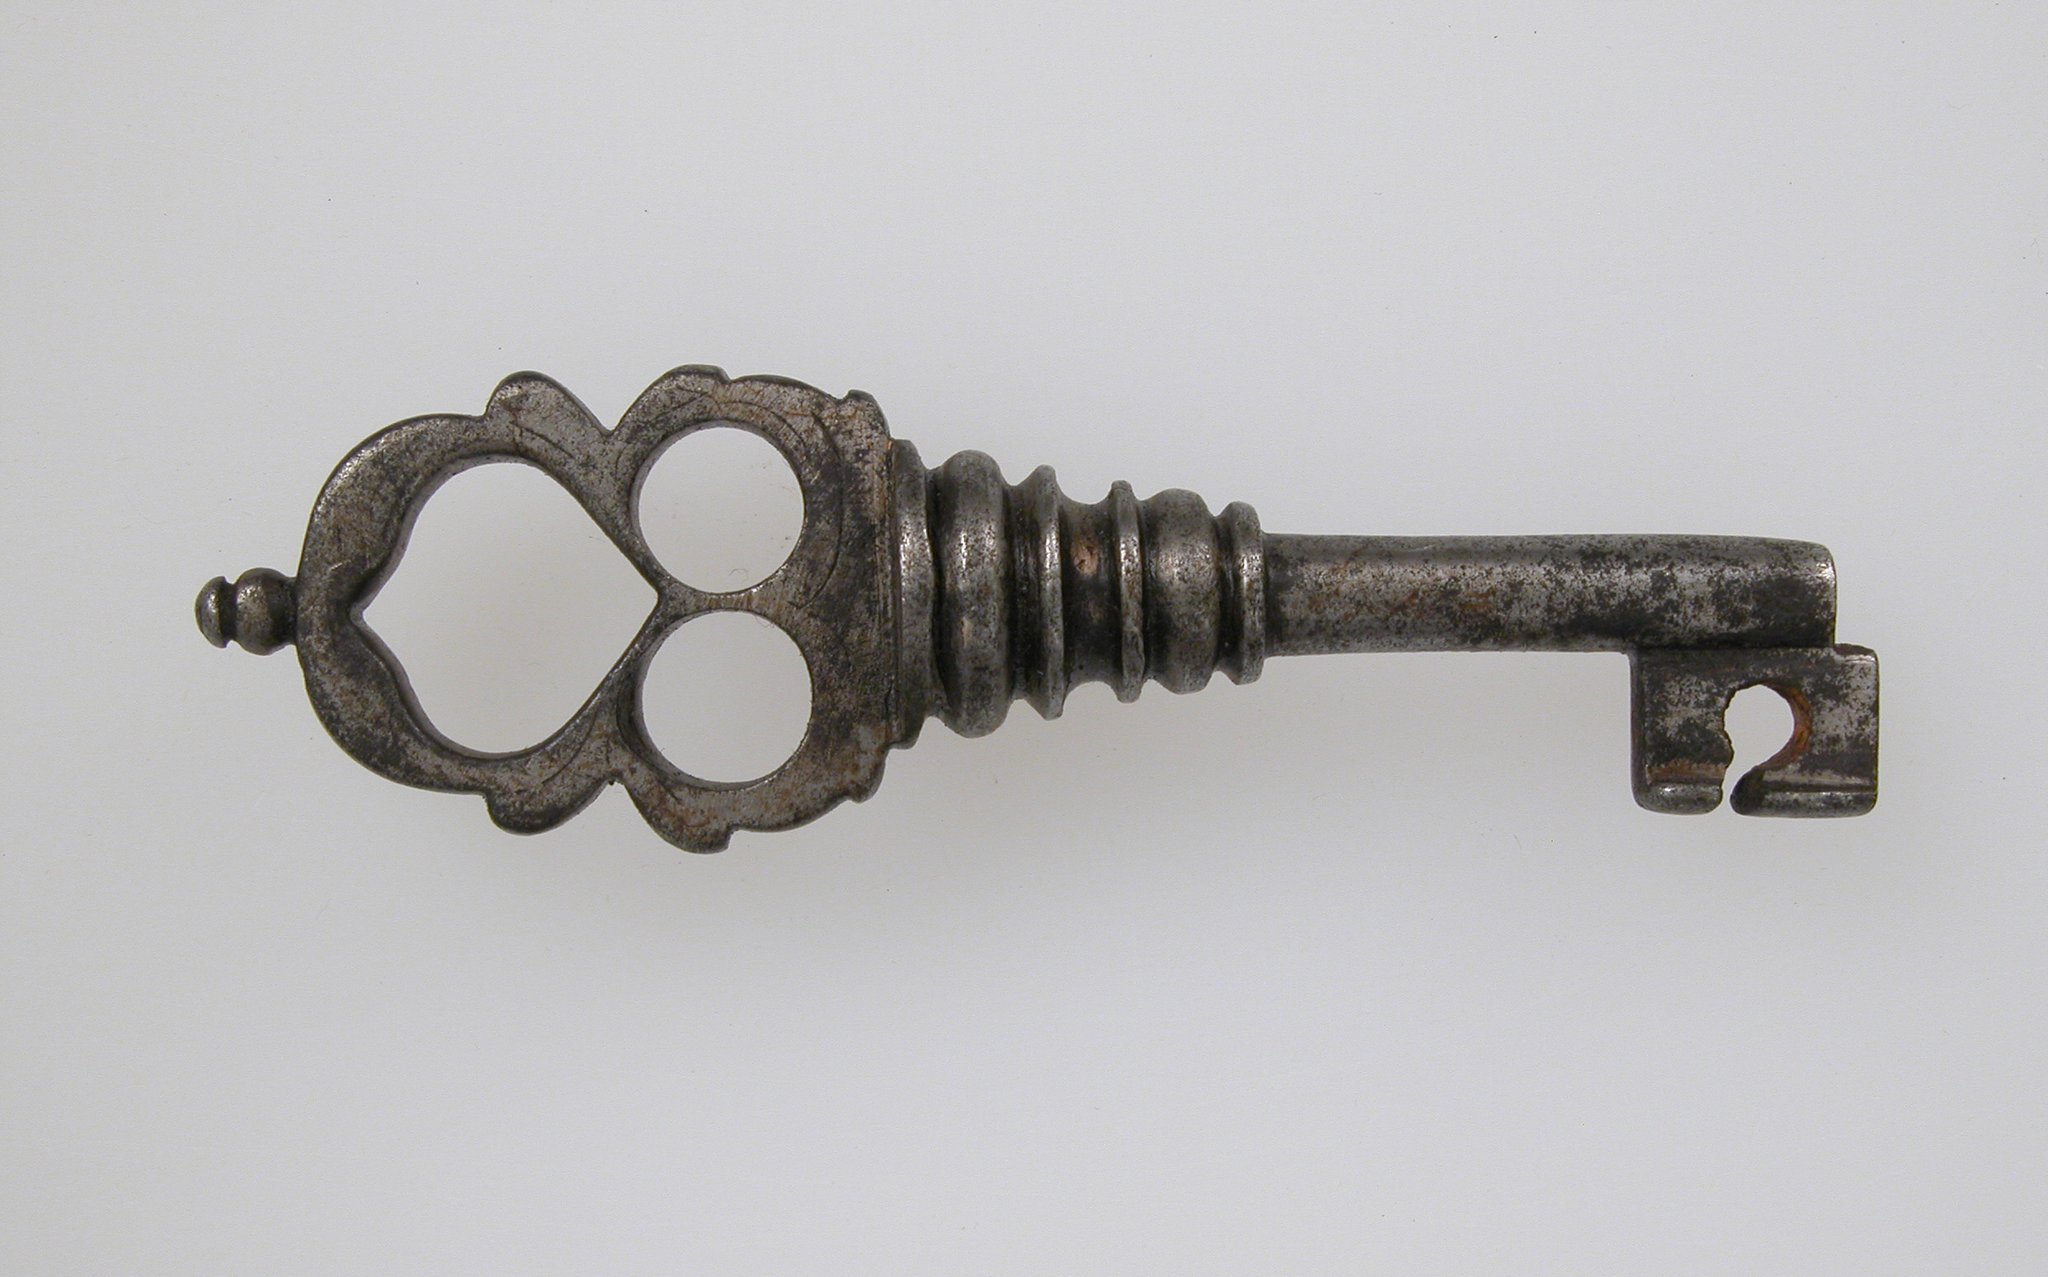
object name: key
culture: german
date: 1401-1500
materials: iron